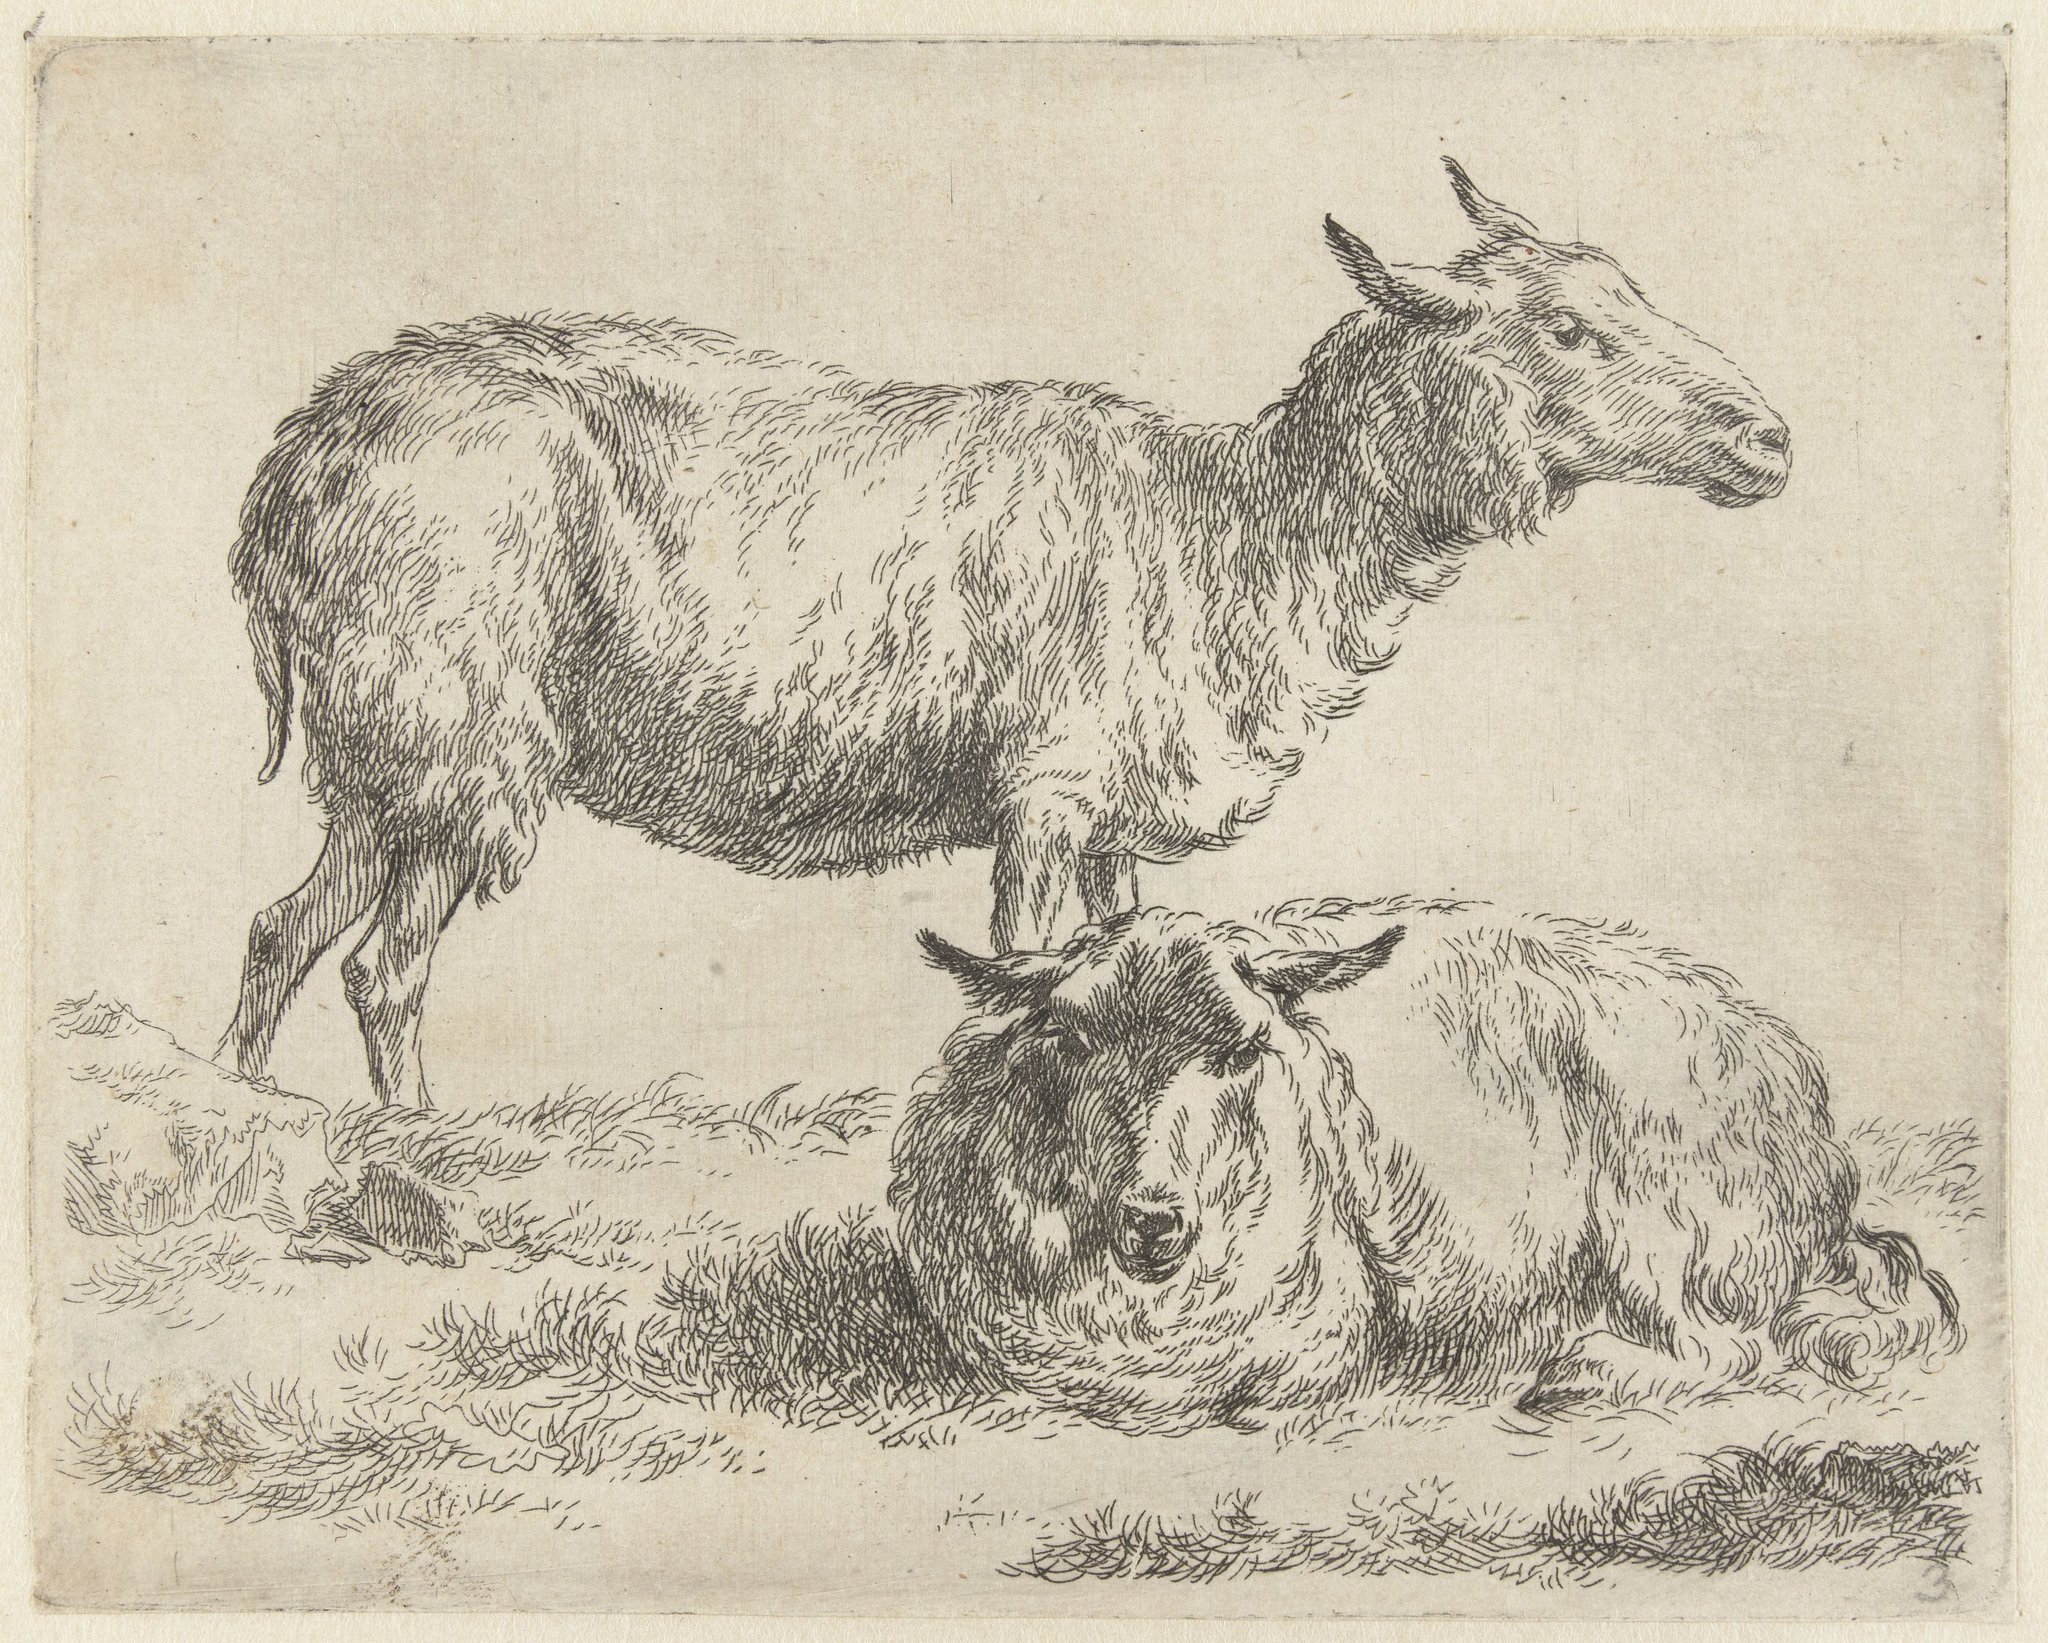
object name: print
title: Staand en liggend schaap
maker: nicolaes pietersz berchem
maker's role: draughtsman, print maker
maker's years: 1620-1683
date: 1648-1652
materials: paper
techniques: etching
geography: netherlands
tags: sheep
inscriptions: collector's mark: Lugt 240